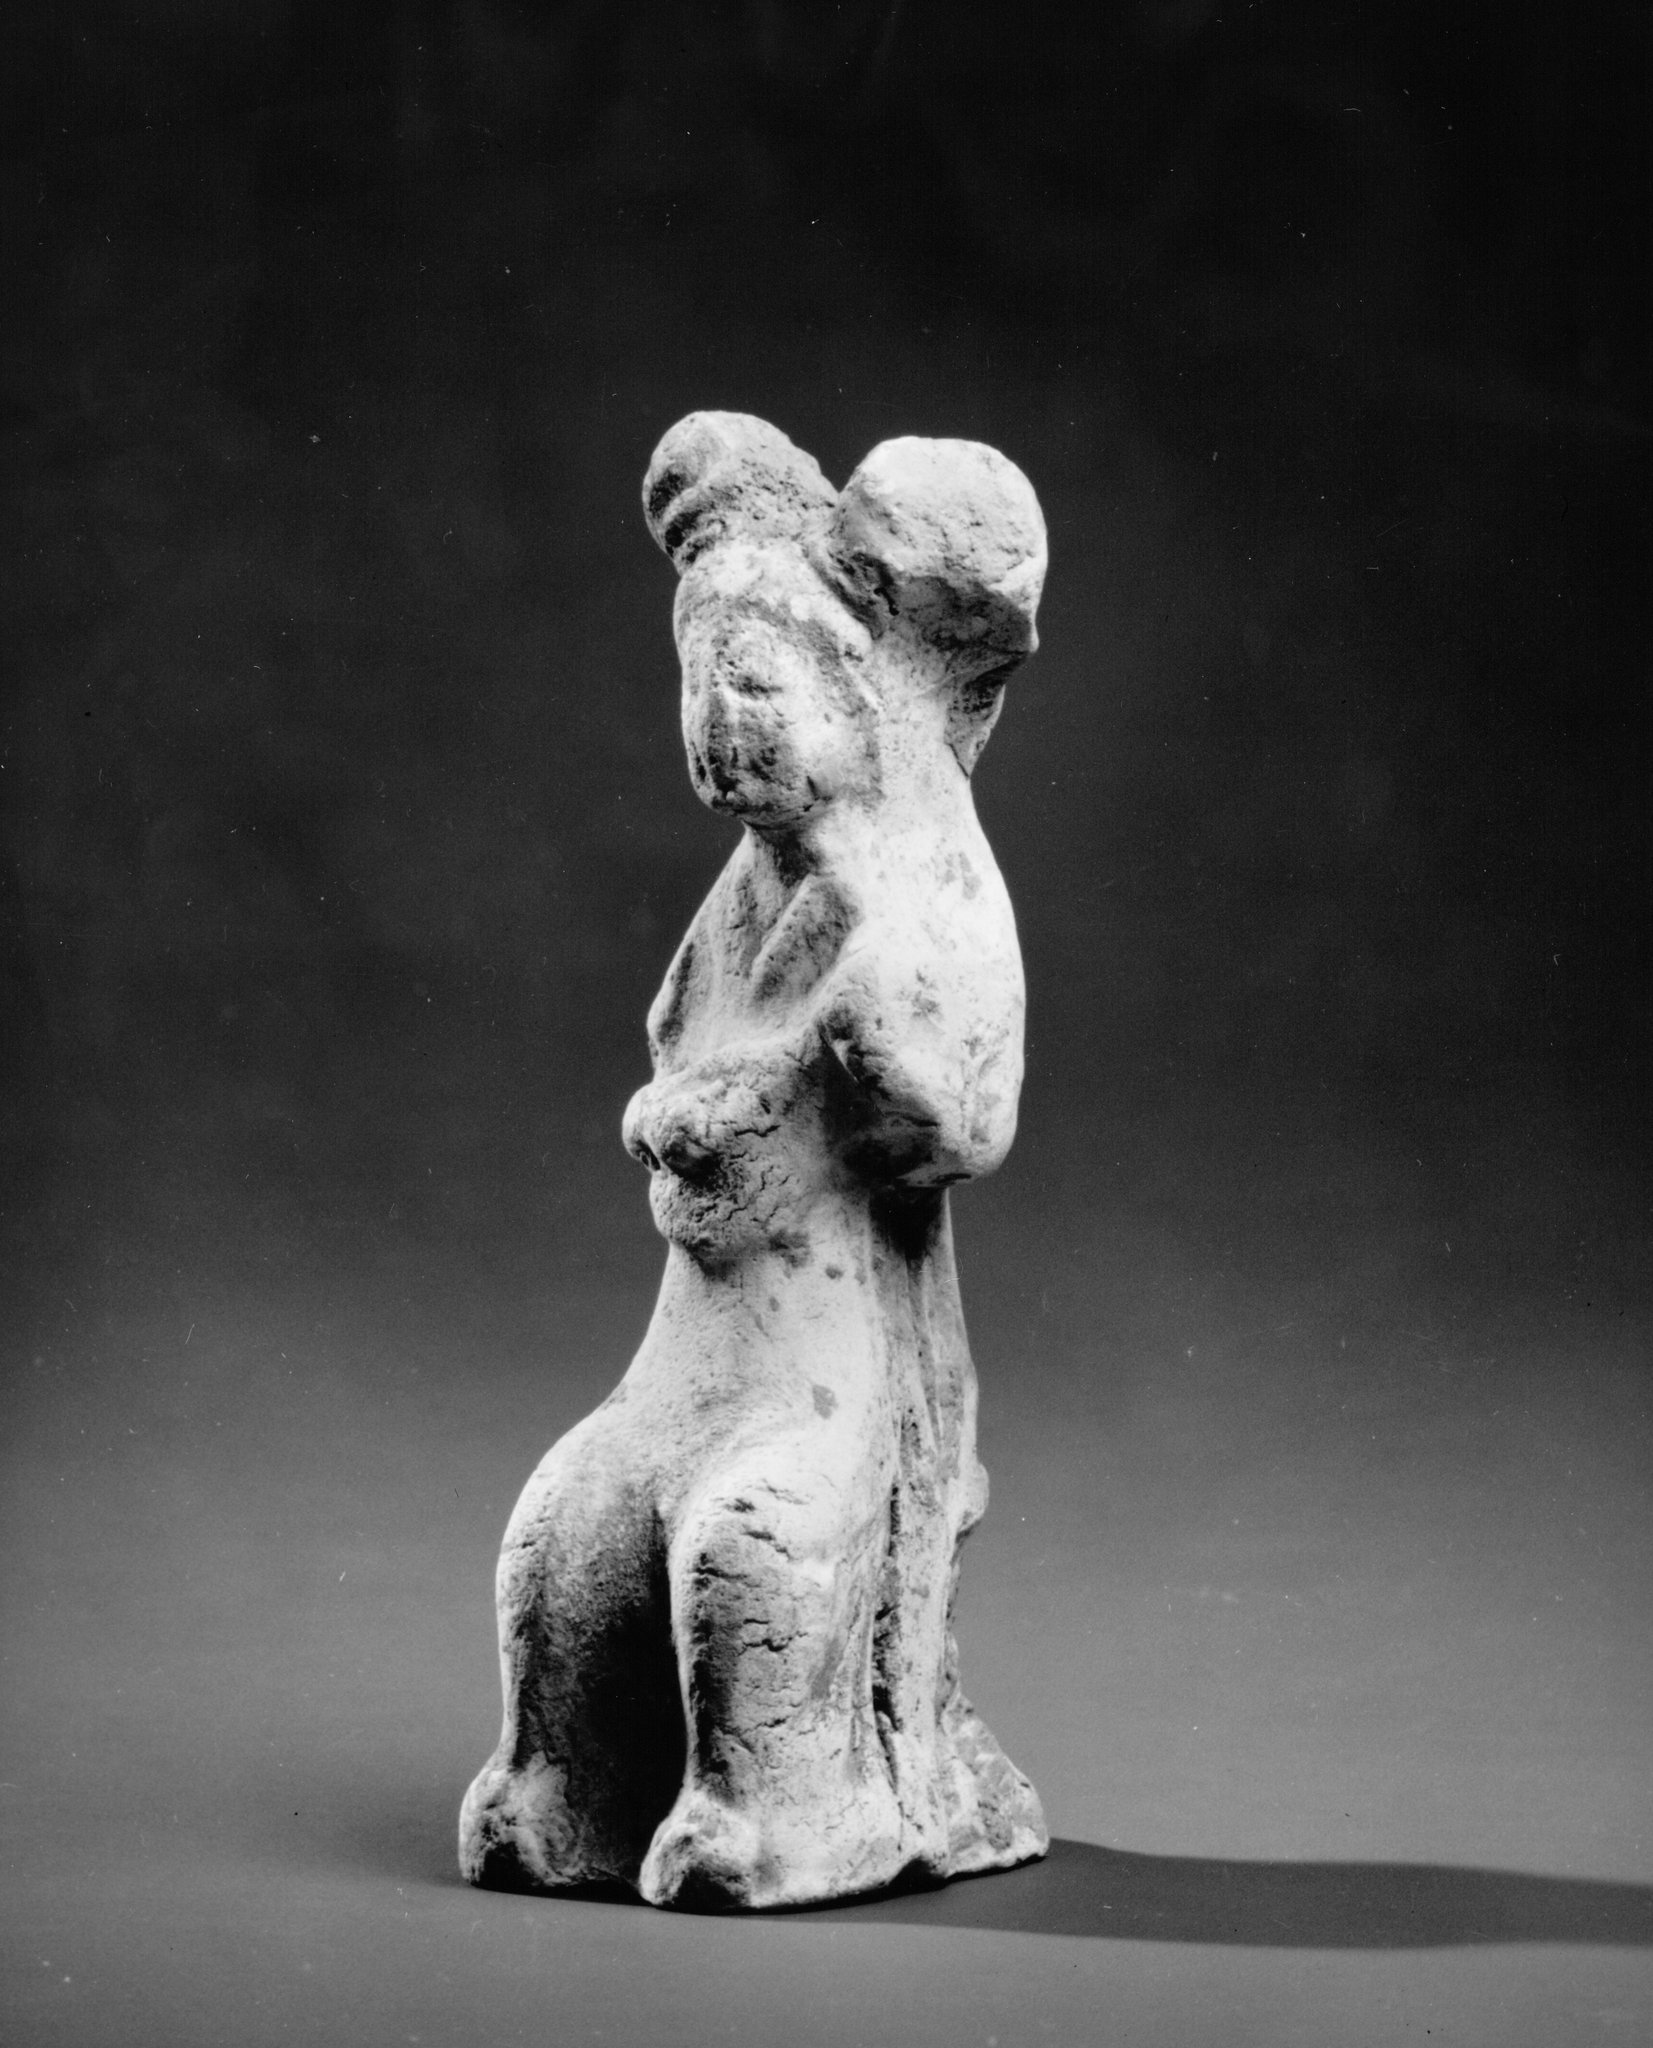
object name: figure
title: Seated female musician with lute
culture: chinese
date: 601-800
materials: earthenware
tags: lutes,musicians